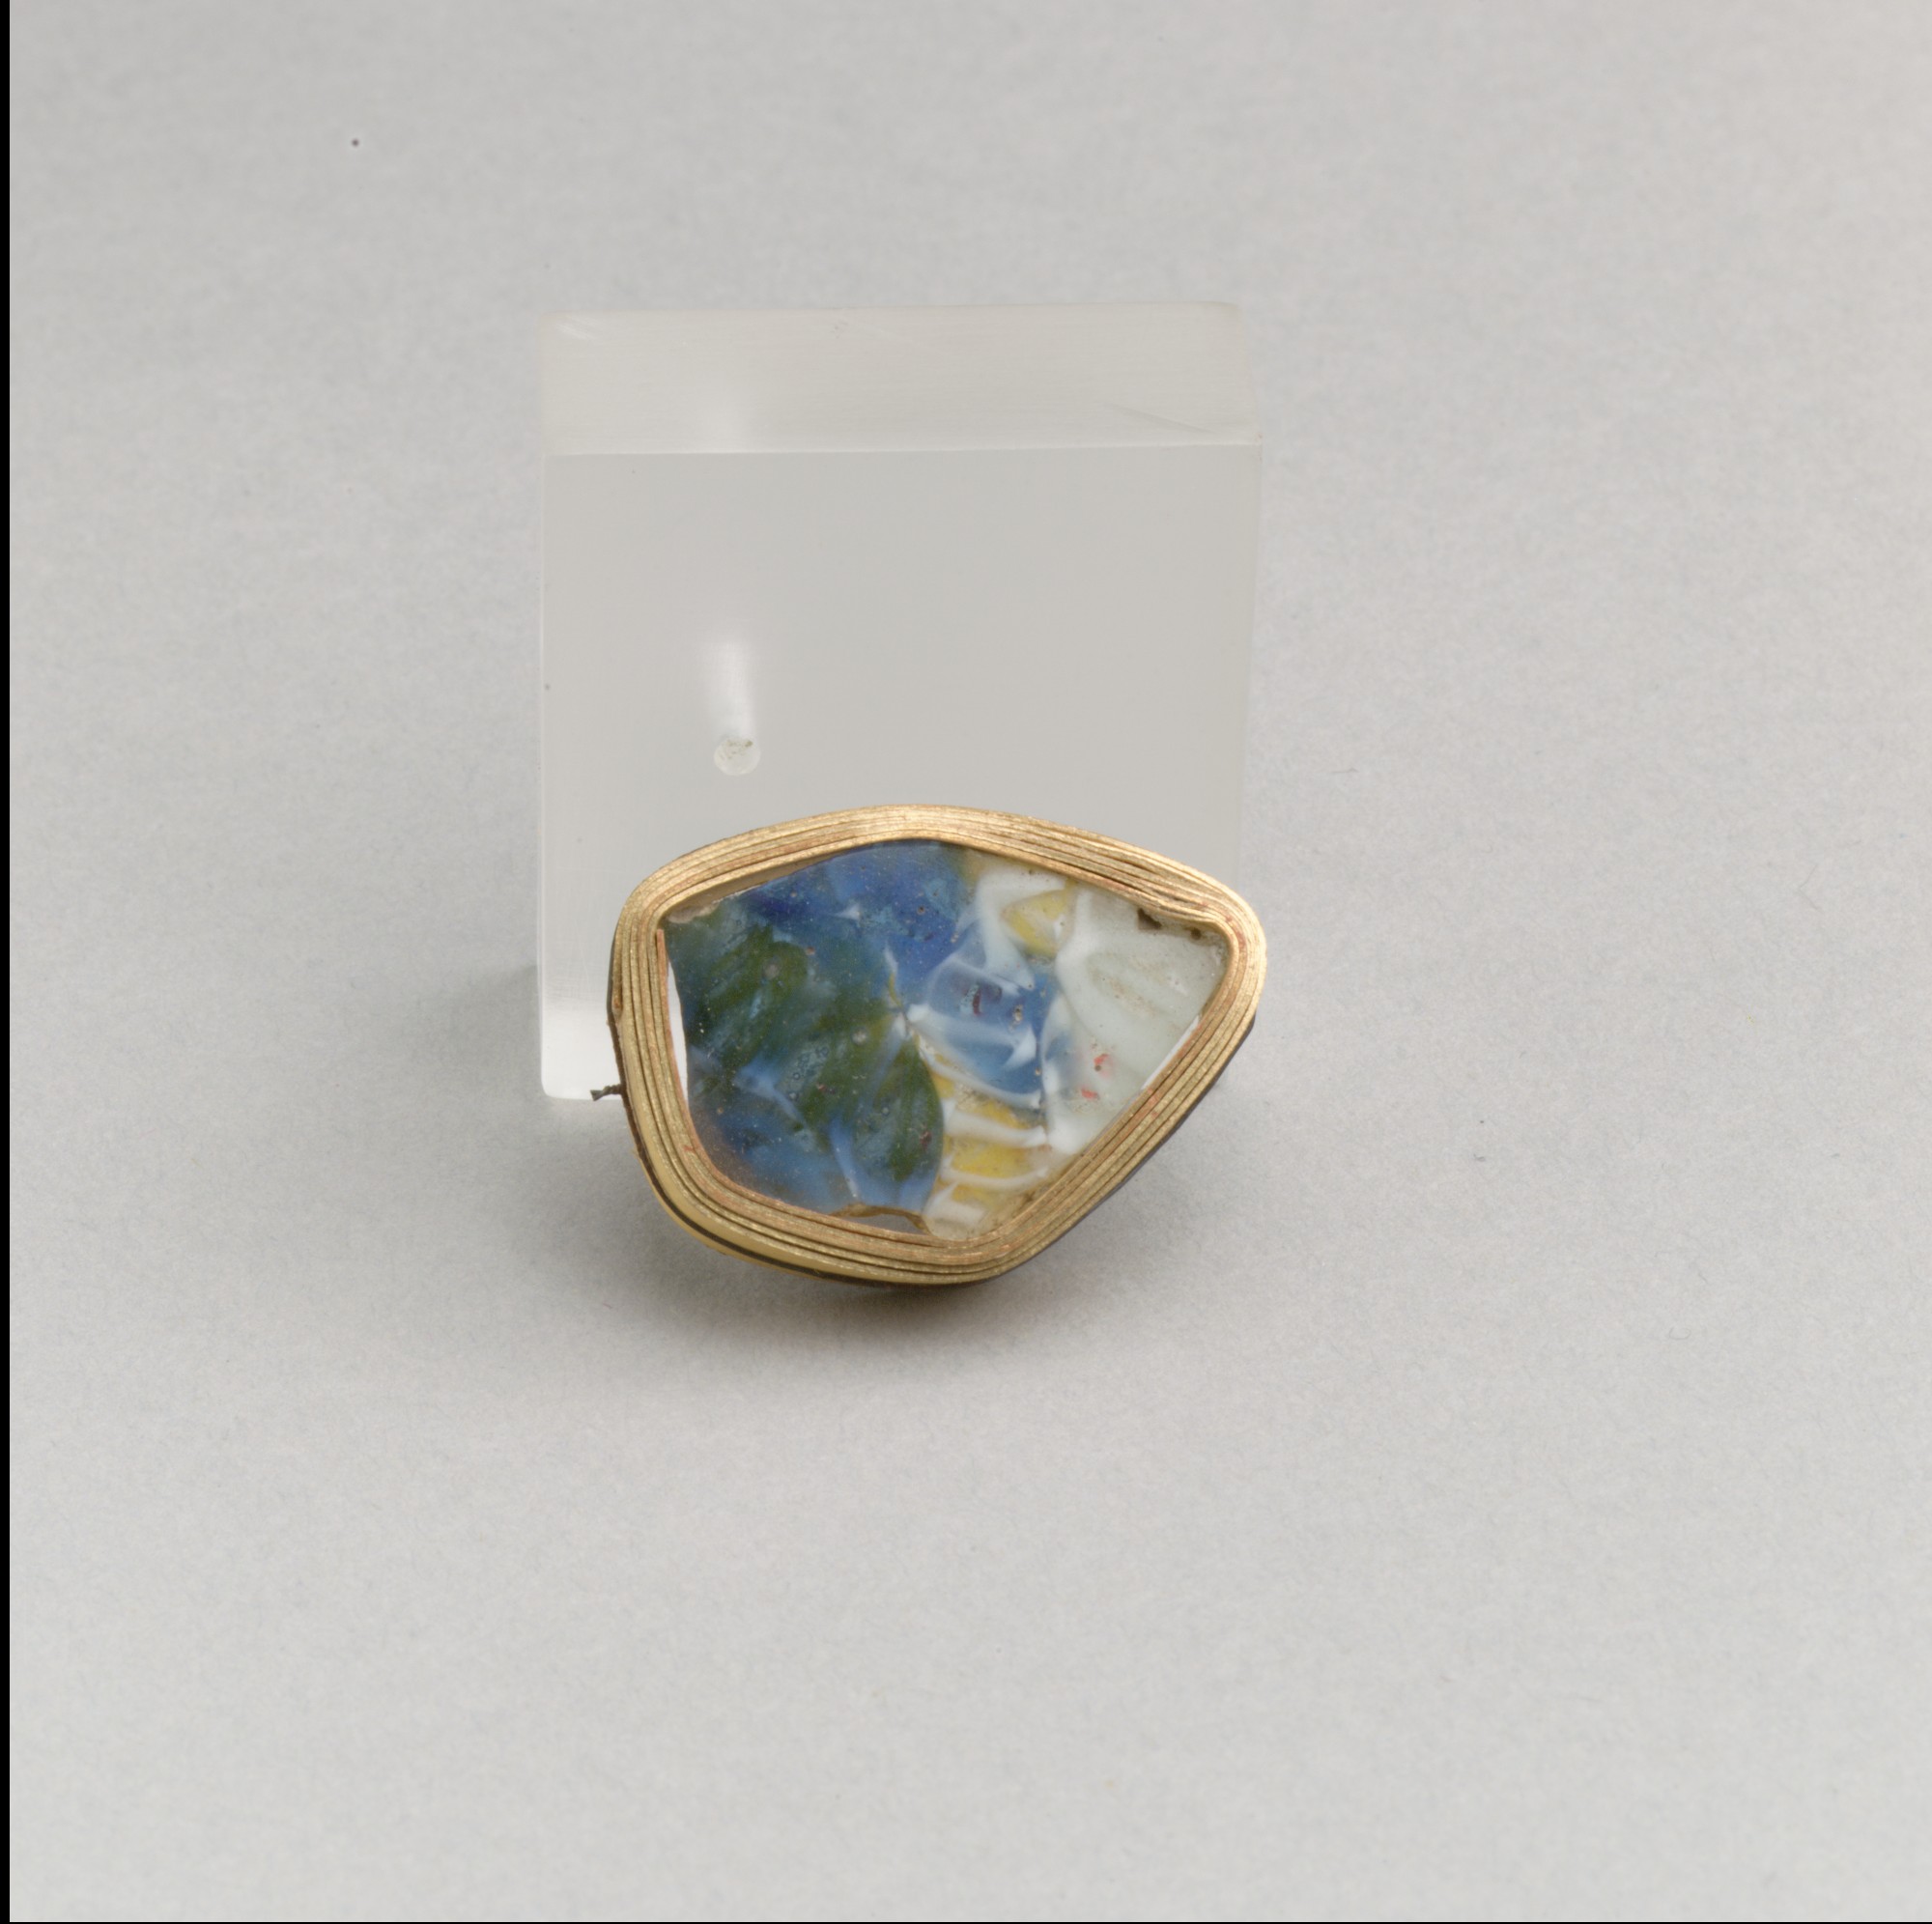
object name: fragment, mosaic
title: Glass mosaic fragment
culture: roman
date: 34 BCE-33 CE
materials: glass